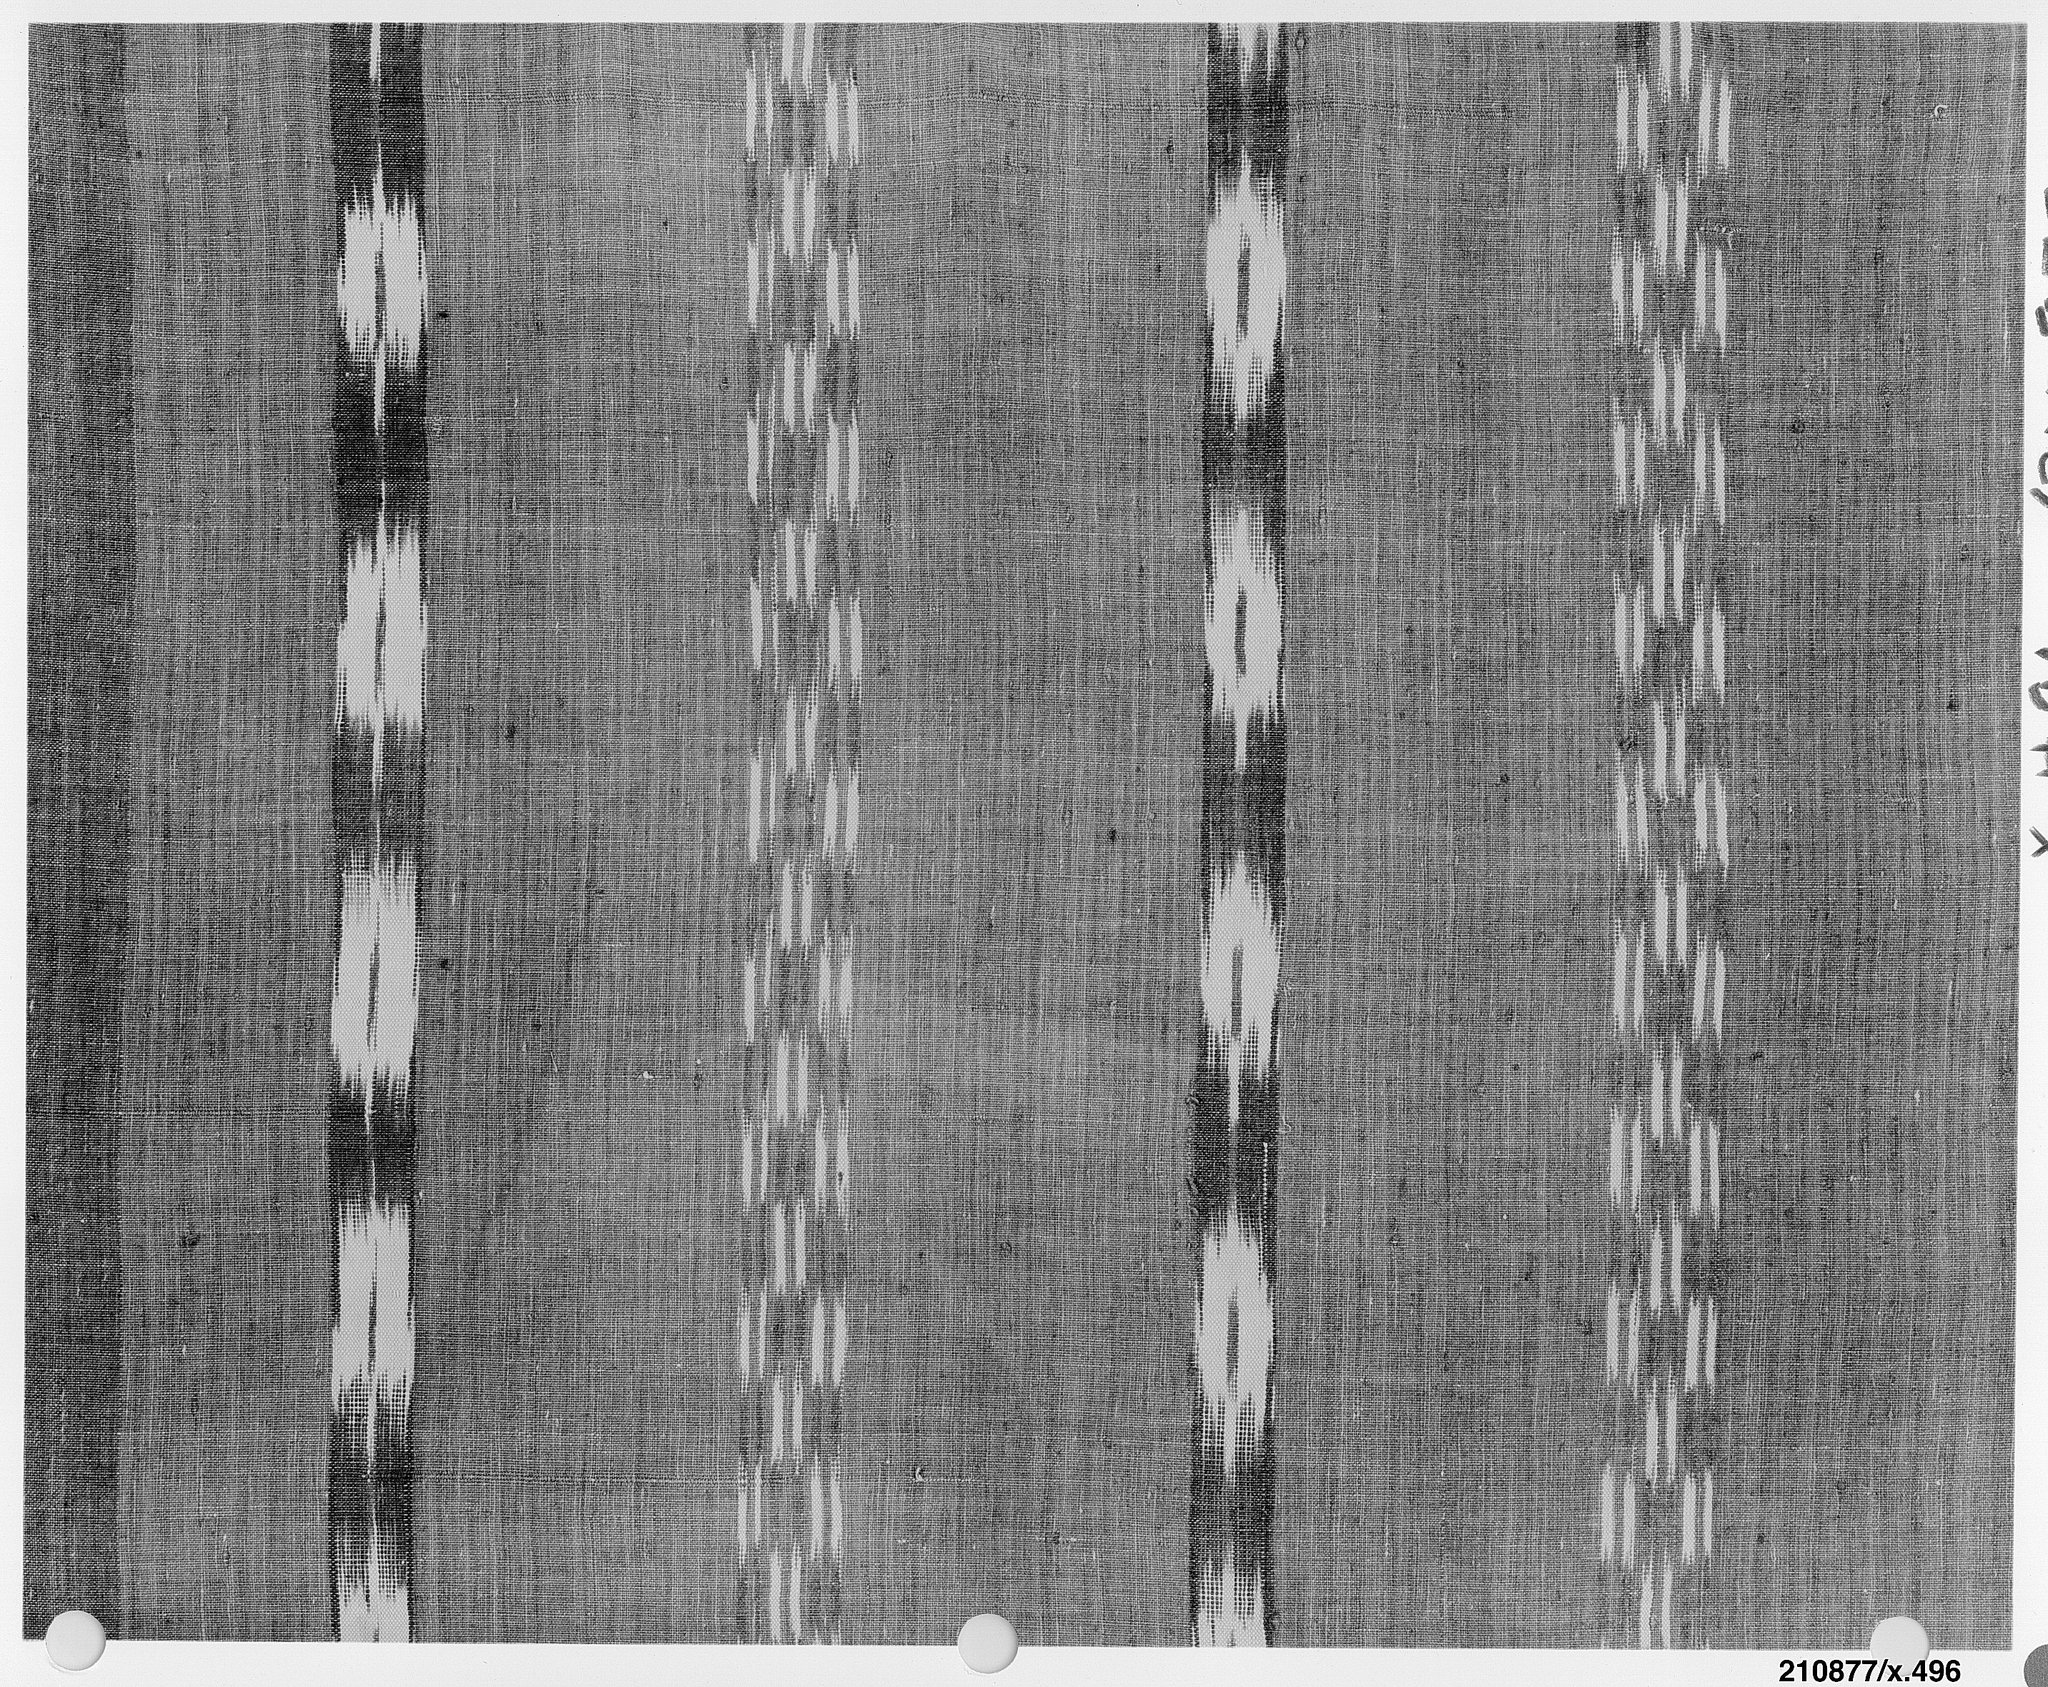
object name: piece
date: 1701-1800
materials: cotton